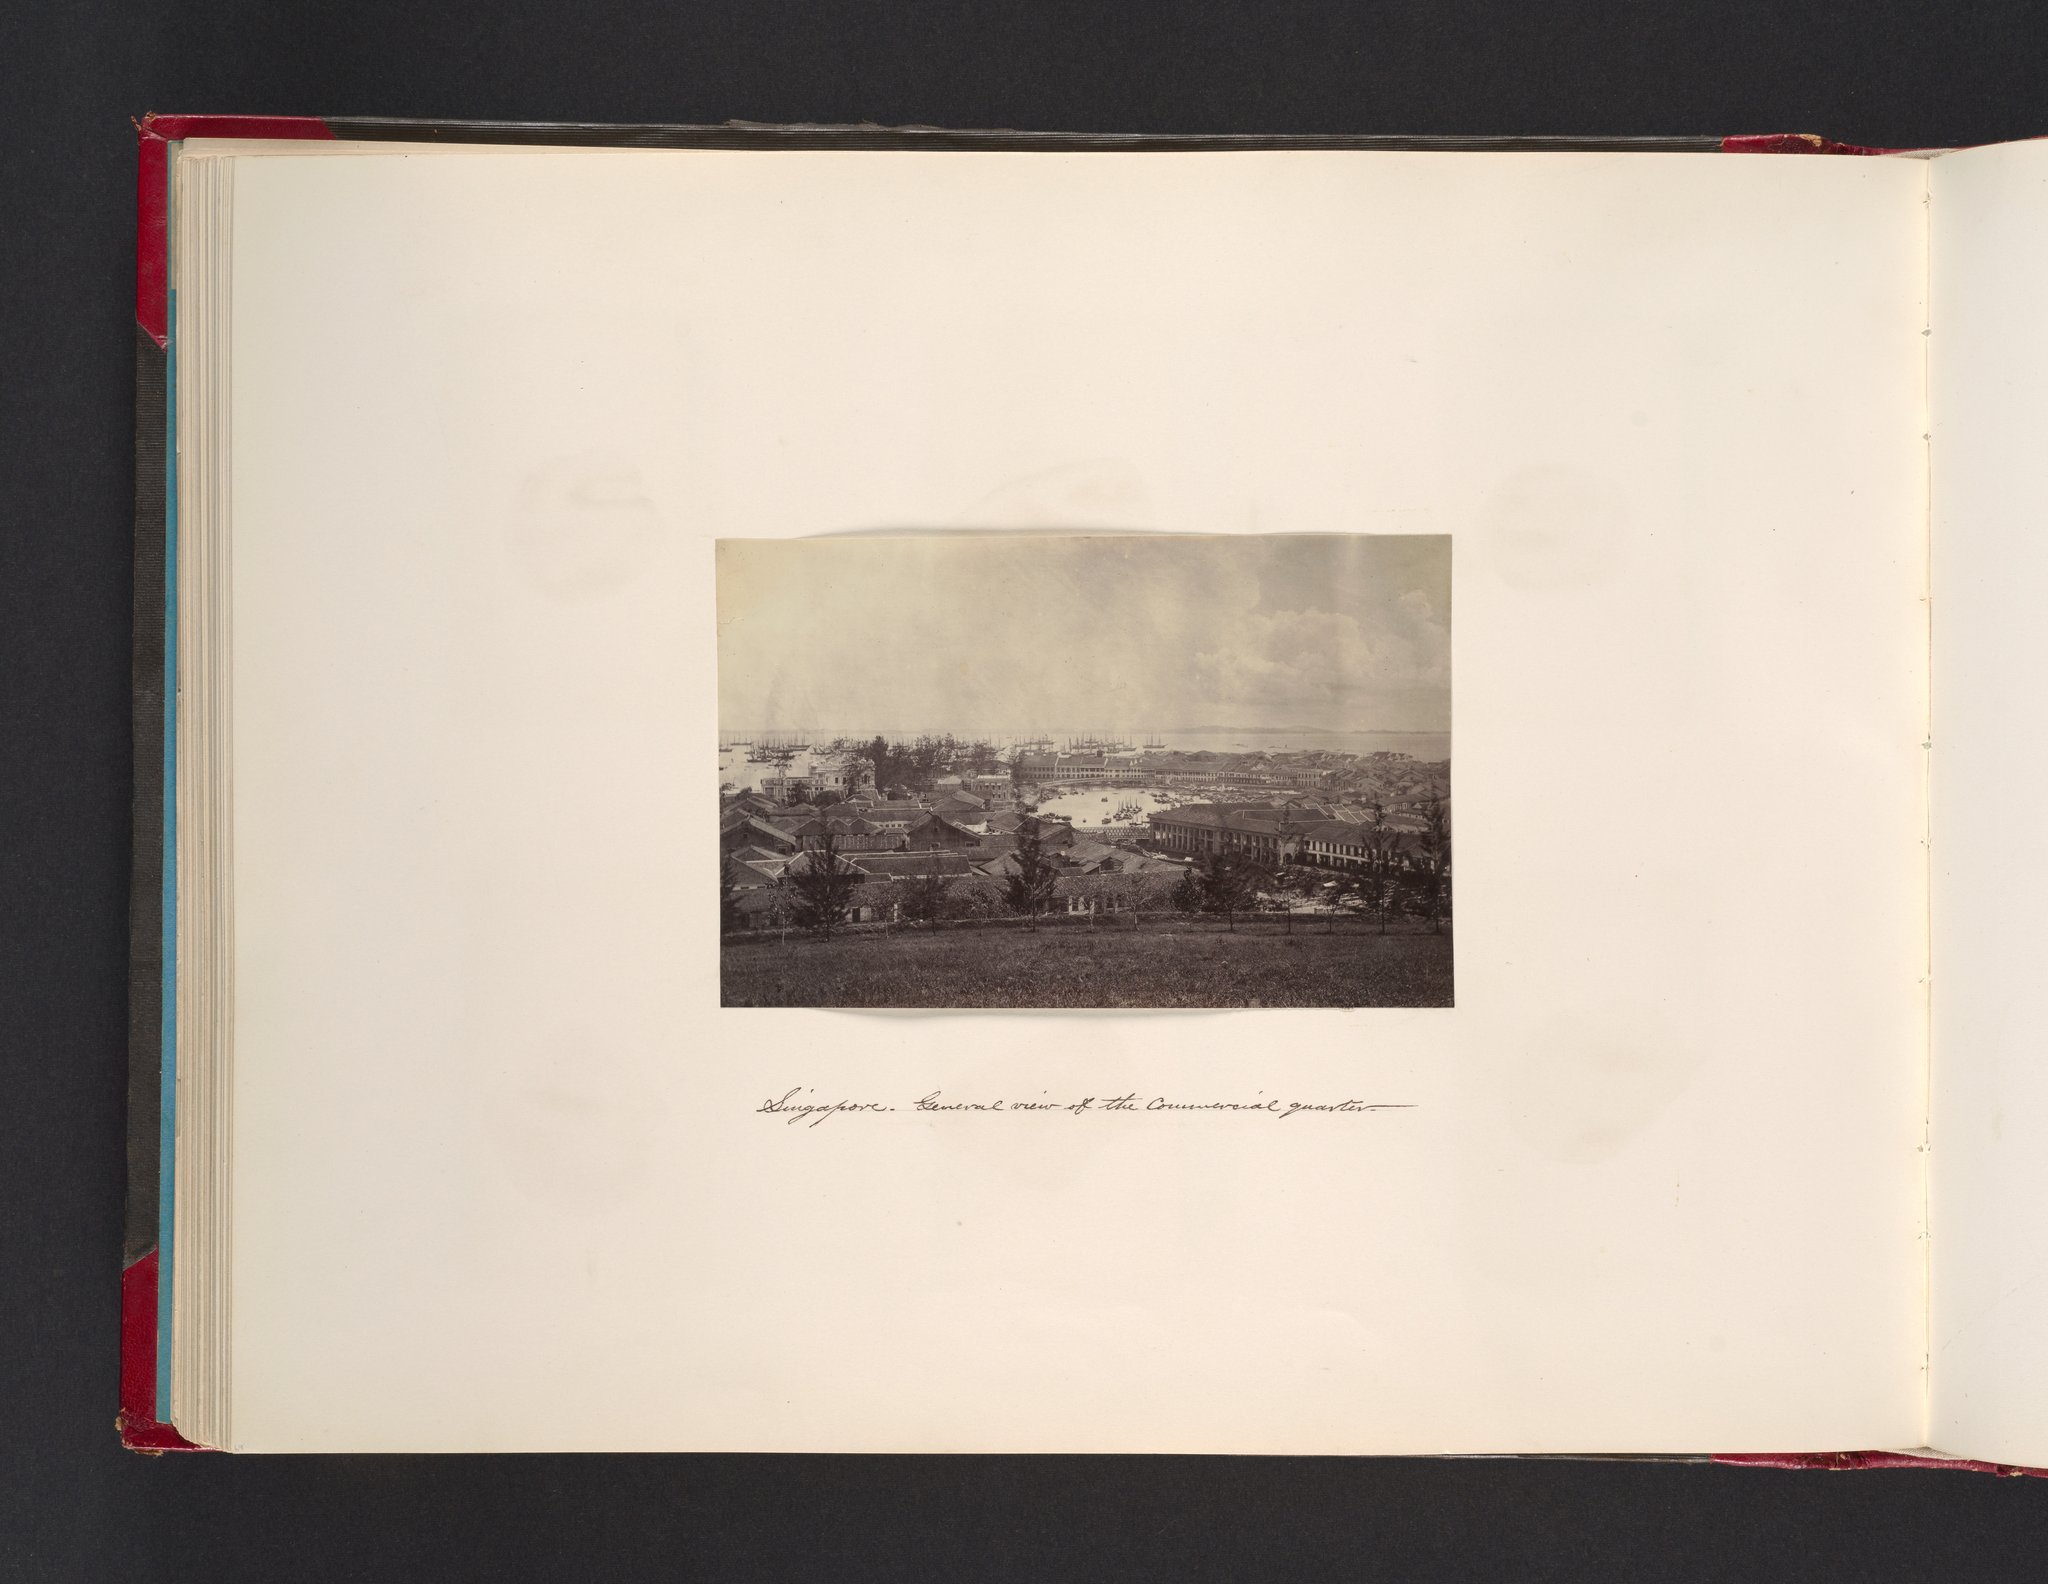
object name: photograph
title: Singapore, General View of the Commercial Quarter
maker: john thomson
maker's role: artist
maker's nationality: british, scottish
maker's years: 1837-1921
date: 1865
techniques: albumen silver print, glass negative